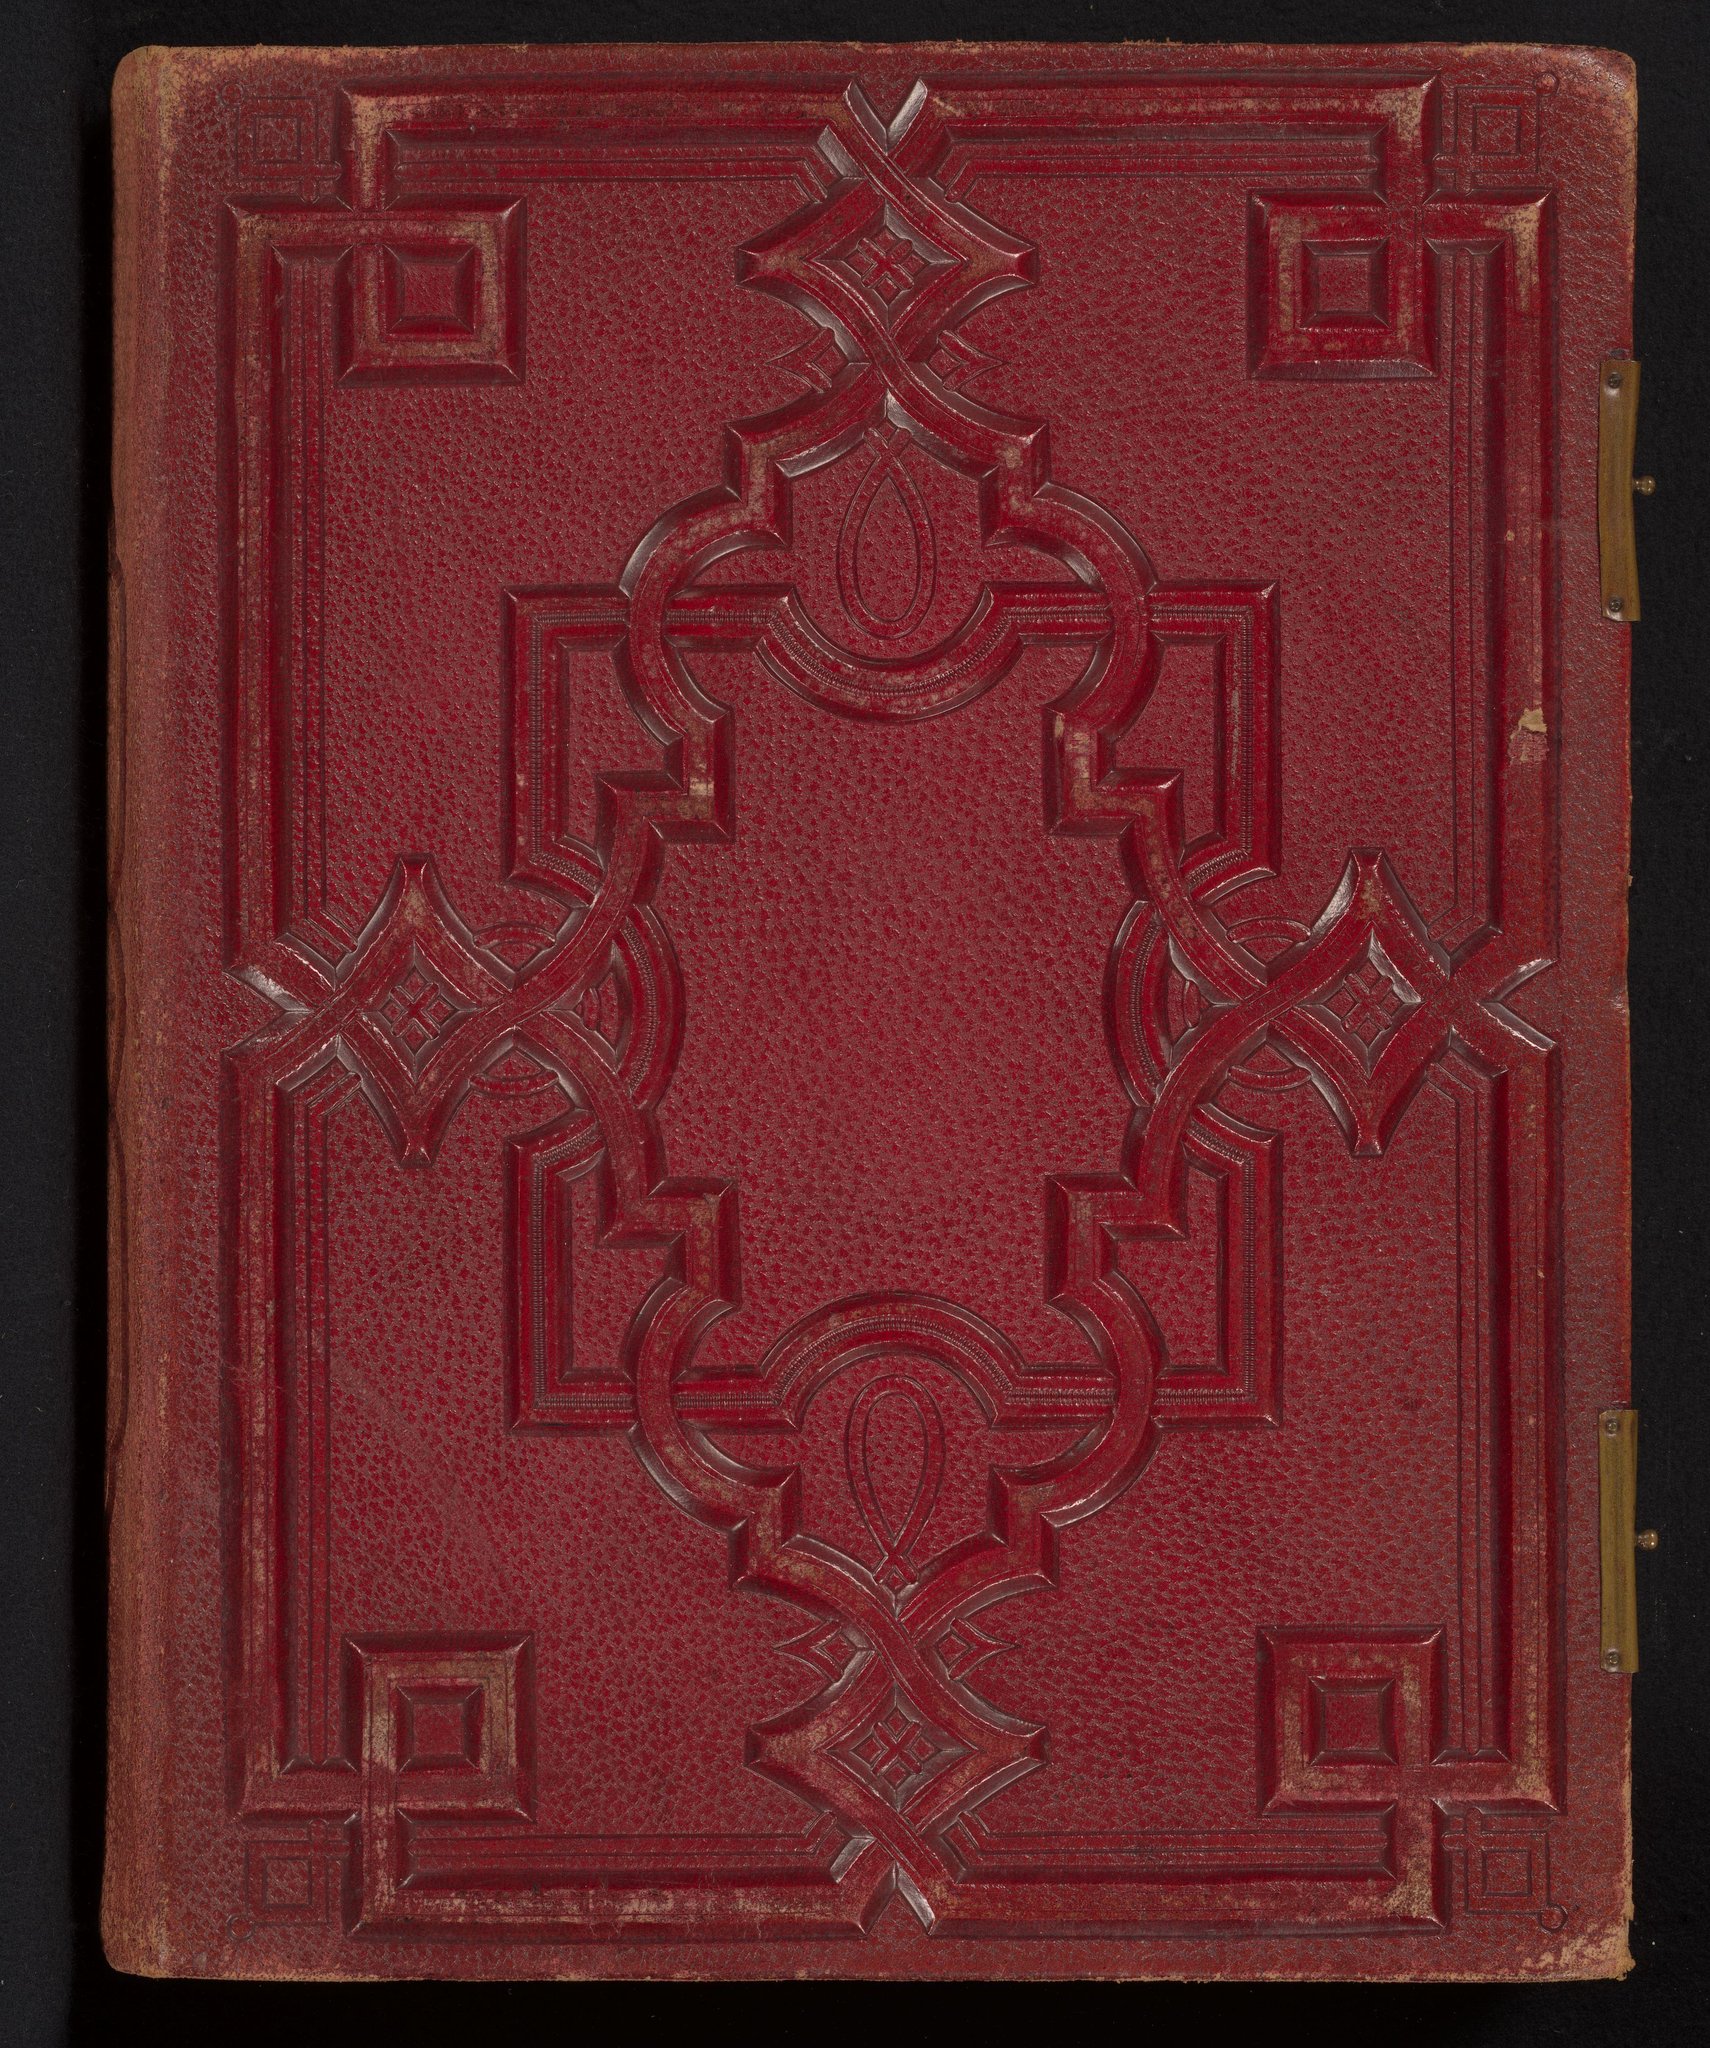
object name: photograph album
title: Reisalbum Nederlands-Indië met 200 foto's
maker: Anonymous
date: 1850-1880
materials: cardboard, copper, leather, paper, photographic support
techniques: albumen print, hand coloring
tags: city-view in general; 'veduta', historical persons - bb - woman, historical persons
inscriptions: collector's mark: ‘Dienst Verspreide Rijkskollekties (...) A 1025’, annotation: ‘200 foto's’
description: Fotoalbum met 200 foto’s op 25 bladen met insteekpasse-partouts op carte-de-visite-formaat. 2 foto's zijn apart opgezet. De foto’s, voornamelijk portretten en enkele stadsgezichten, hebben betrekking op voormalig Nederlands-Indië in de periode 1850-1900. Geportretteerd zijn vooral: Chinezen, Singaporezen (met name door Lambert & Co), Indonesiërs (door Woodbury & Page) en Japanners (door een anonieme fotograaf). De eerste foto is een portret van gouverneur-generaal Pieter Mijer. De meeste personen zijn geportretteerd met koopwaar, in uniform of traditionele kleding, of tijdens een ritueel. De diversiteit qua leeftijd, geslacht en handelingen is groot, waardoor het een representatie wordt van de Oost- en Zuidoost-Aziatische bevolking in die periode. Bijgevoegd zit een handgeschreven lijst met beschrijvingen per foto.